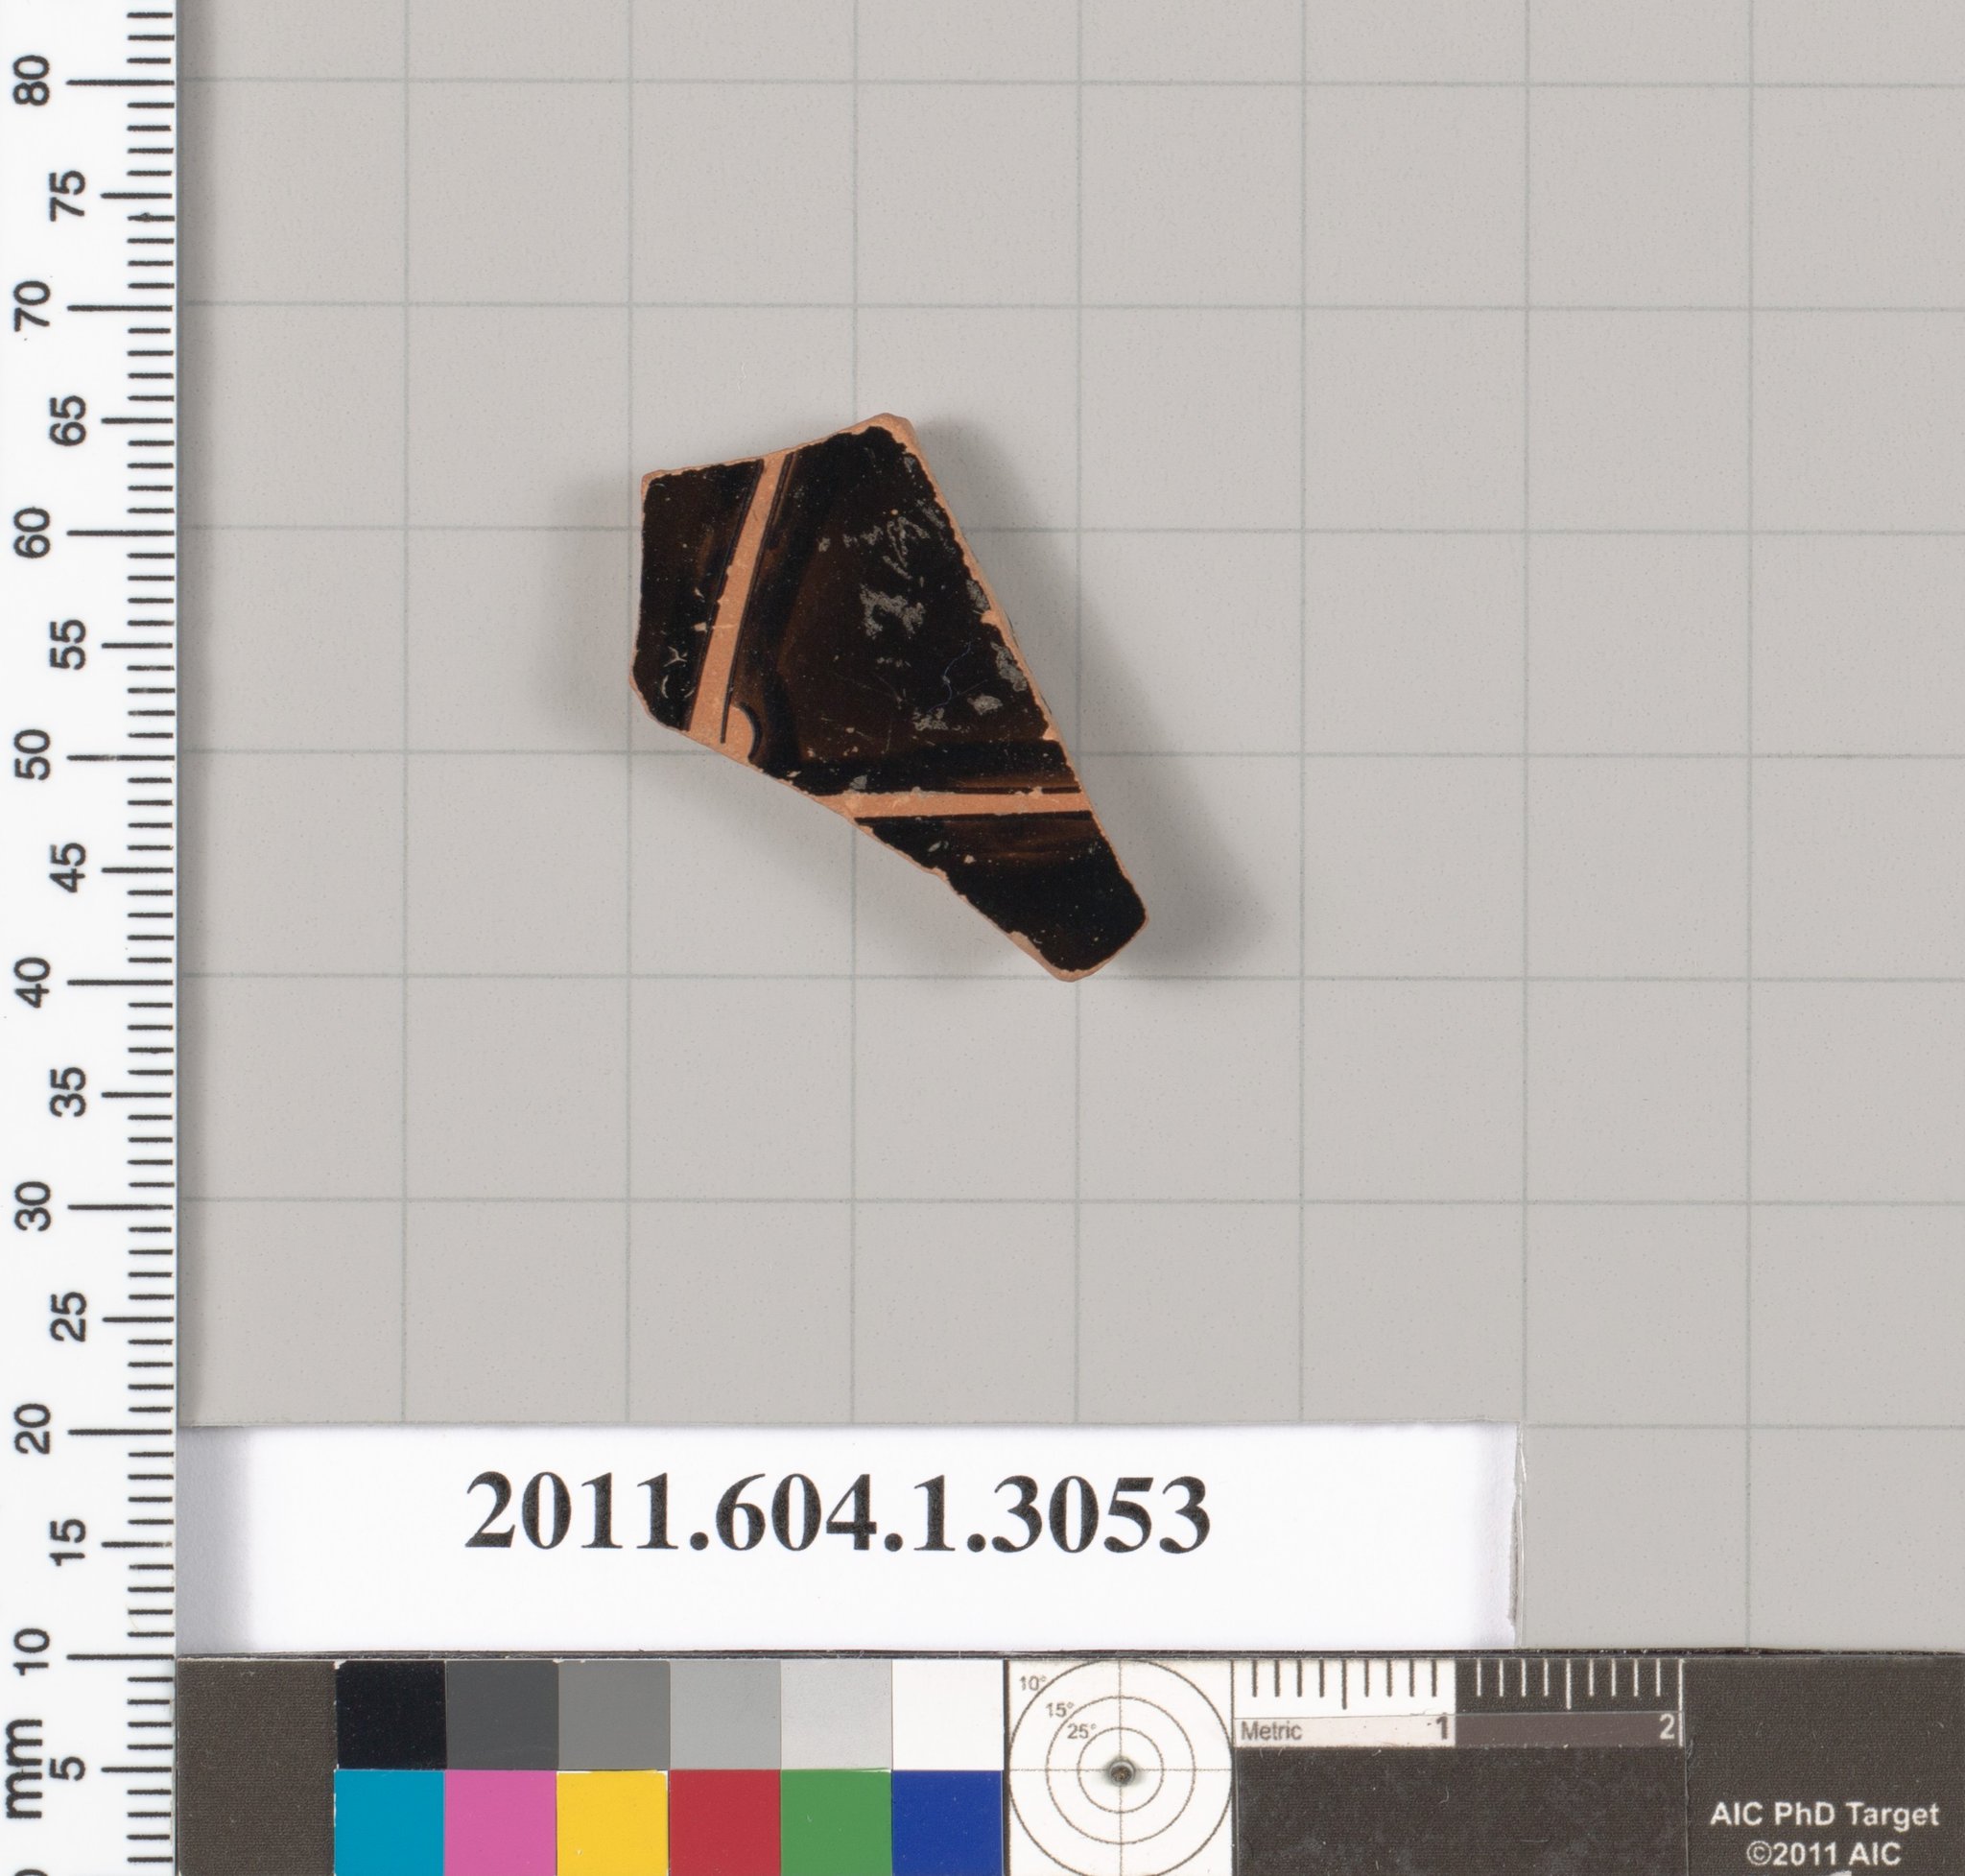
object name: kylix fragment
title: Terracotta fragment of a kylix (drinking cup)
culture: greek, attic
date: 475-451 BCE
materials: terracotta